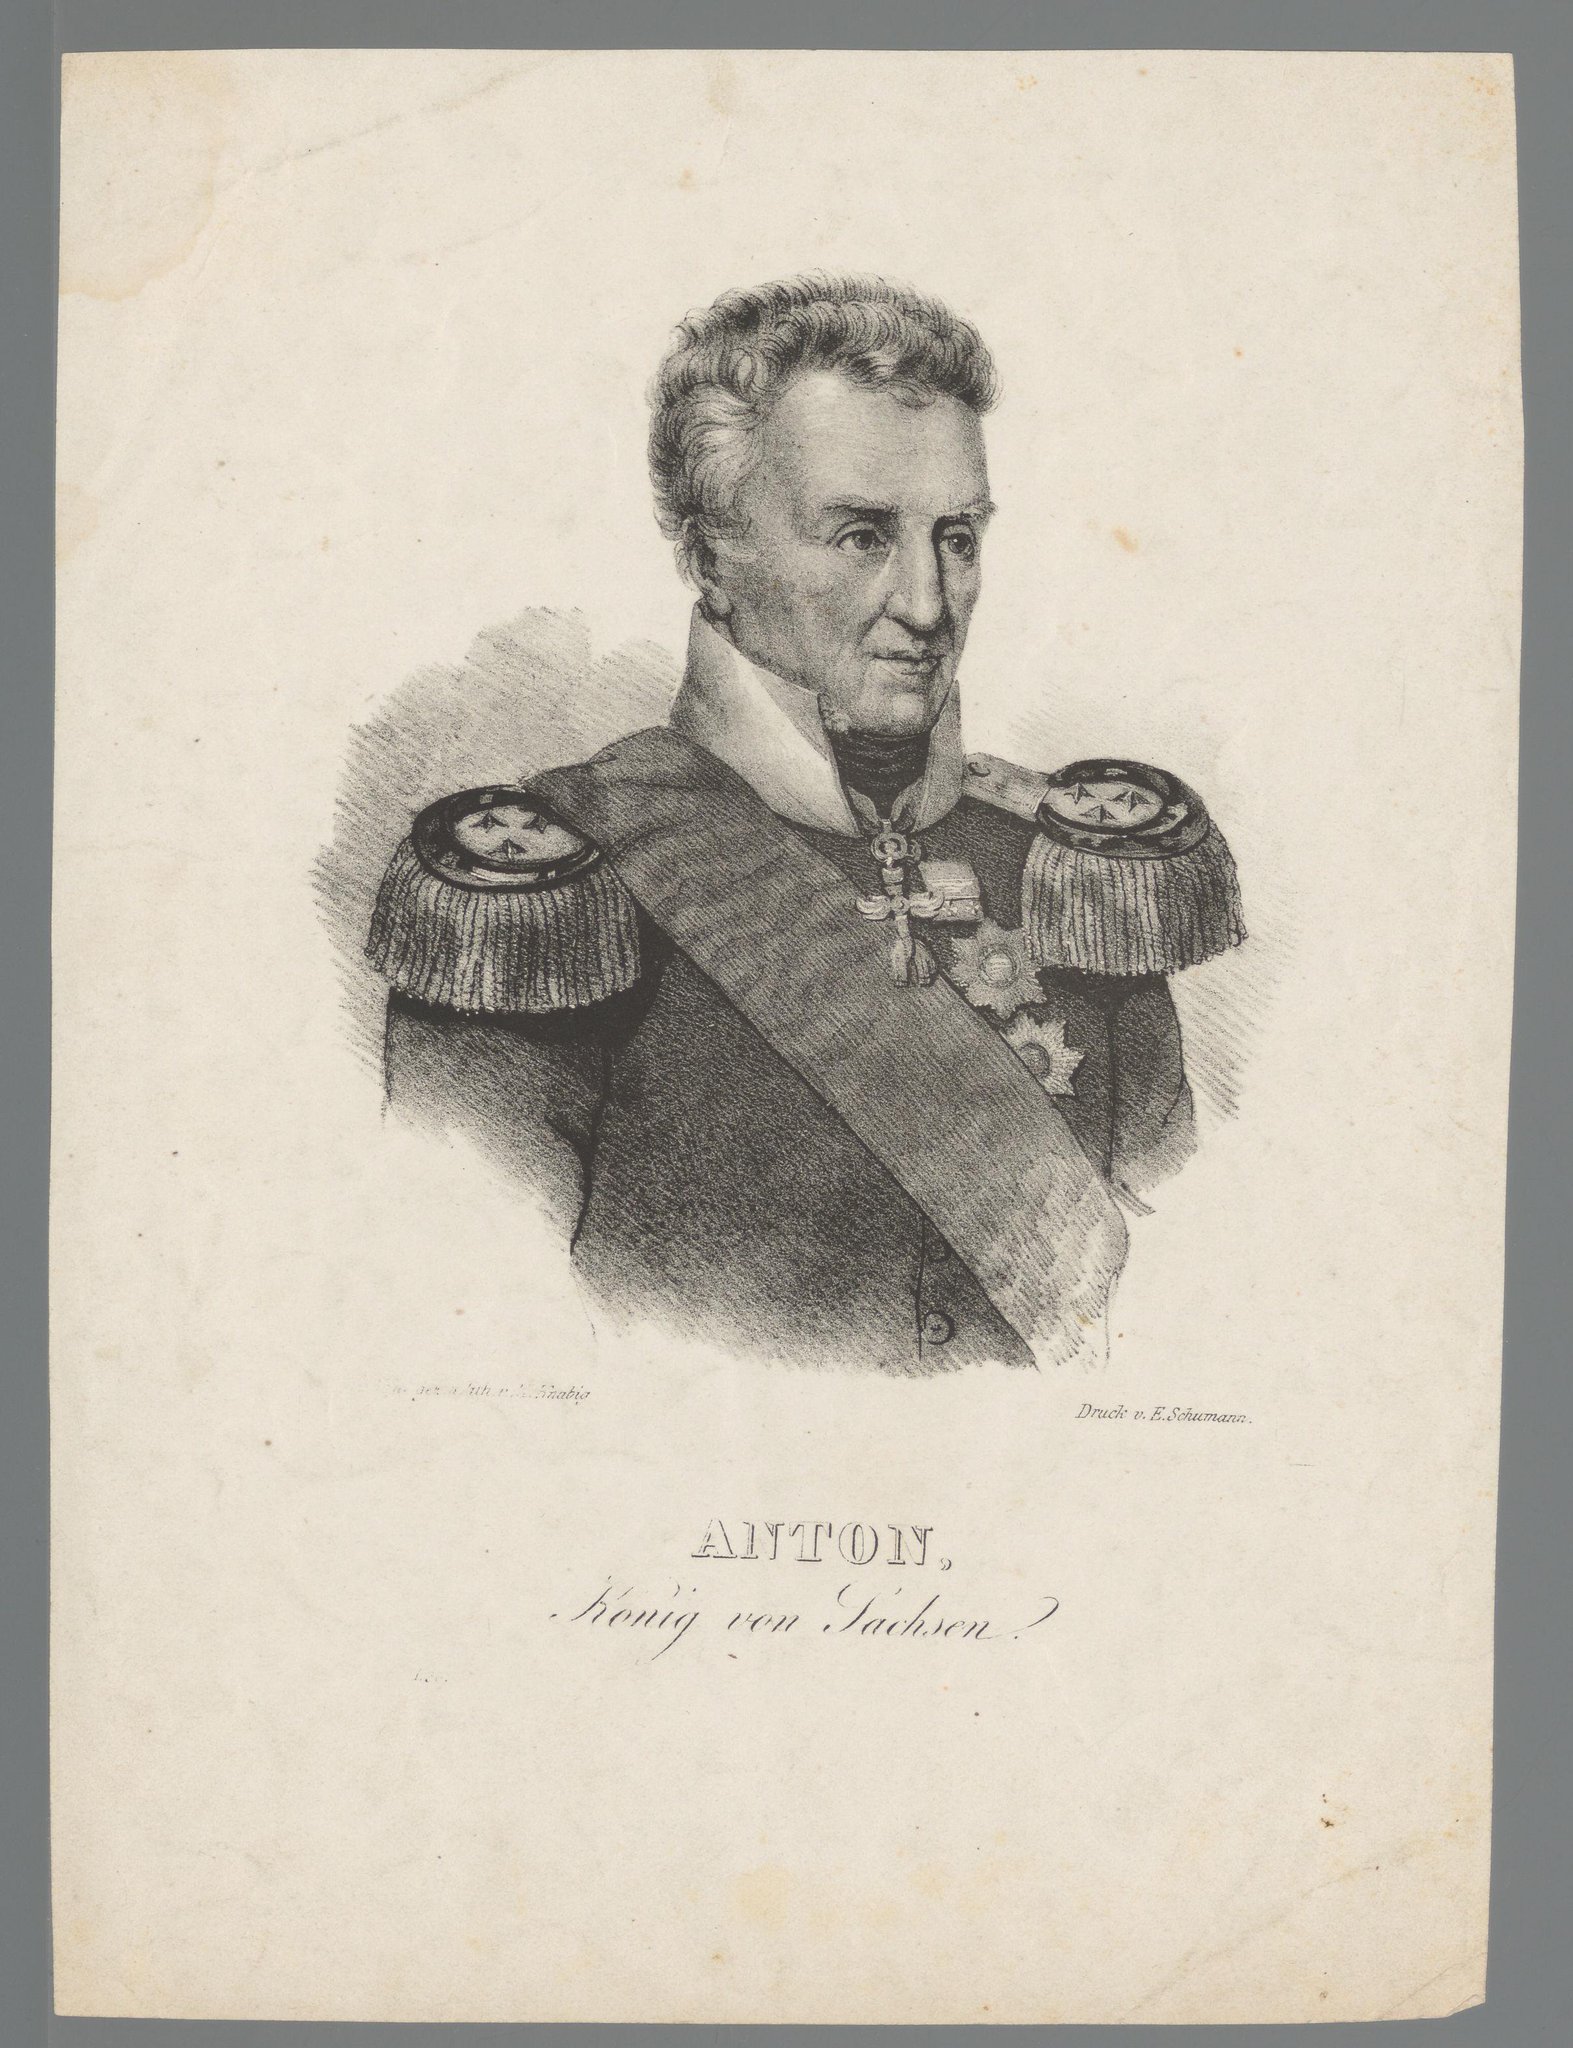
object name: print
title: Anton, König von Sachsen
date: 1814-1876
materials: paper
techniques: lithograph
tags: adult man, historical persons, knighthood order of the golden fleece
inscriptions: collector's mark: Lugt 2228